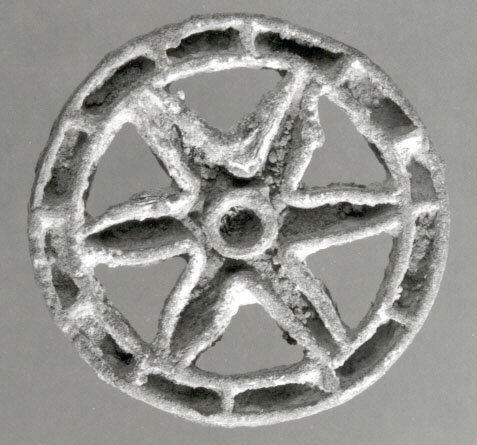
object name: stamp seal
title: Compartmented stamp seal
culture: bactria-margiana archaeological complex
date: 2333-1668 BCE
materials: copper alloy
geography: bactria-margiana